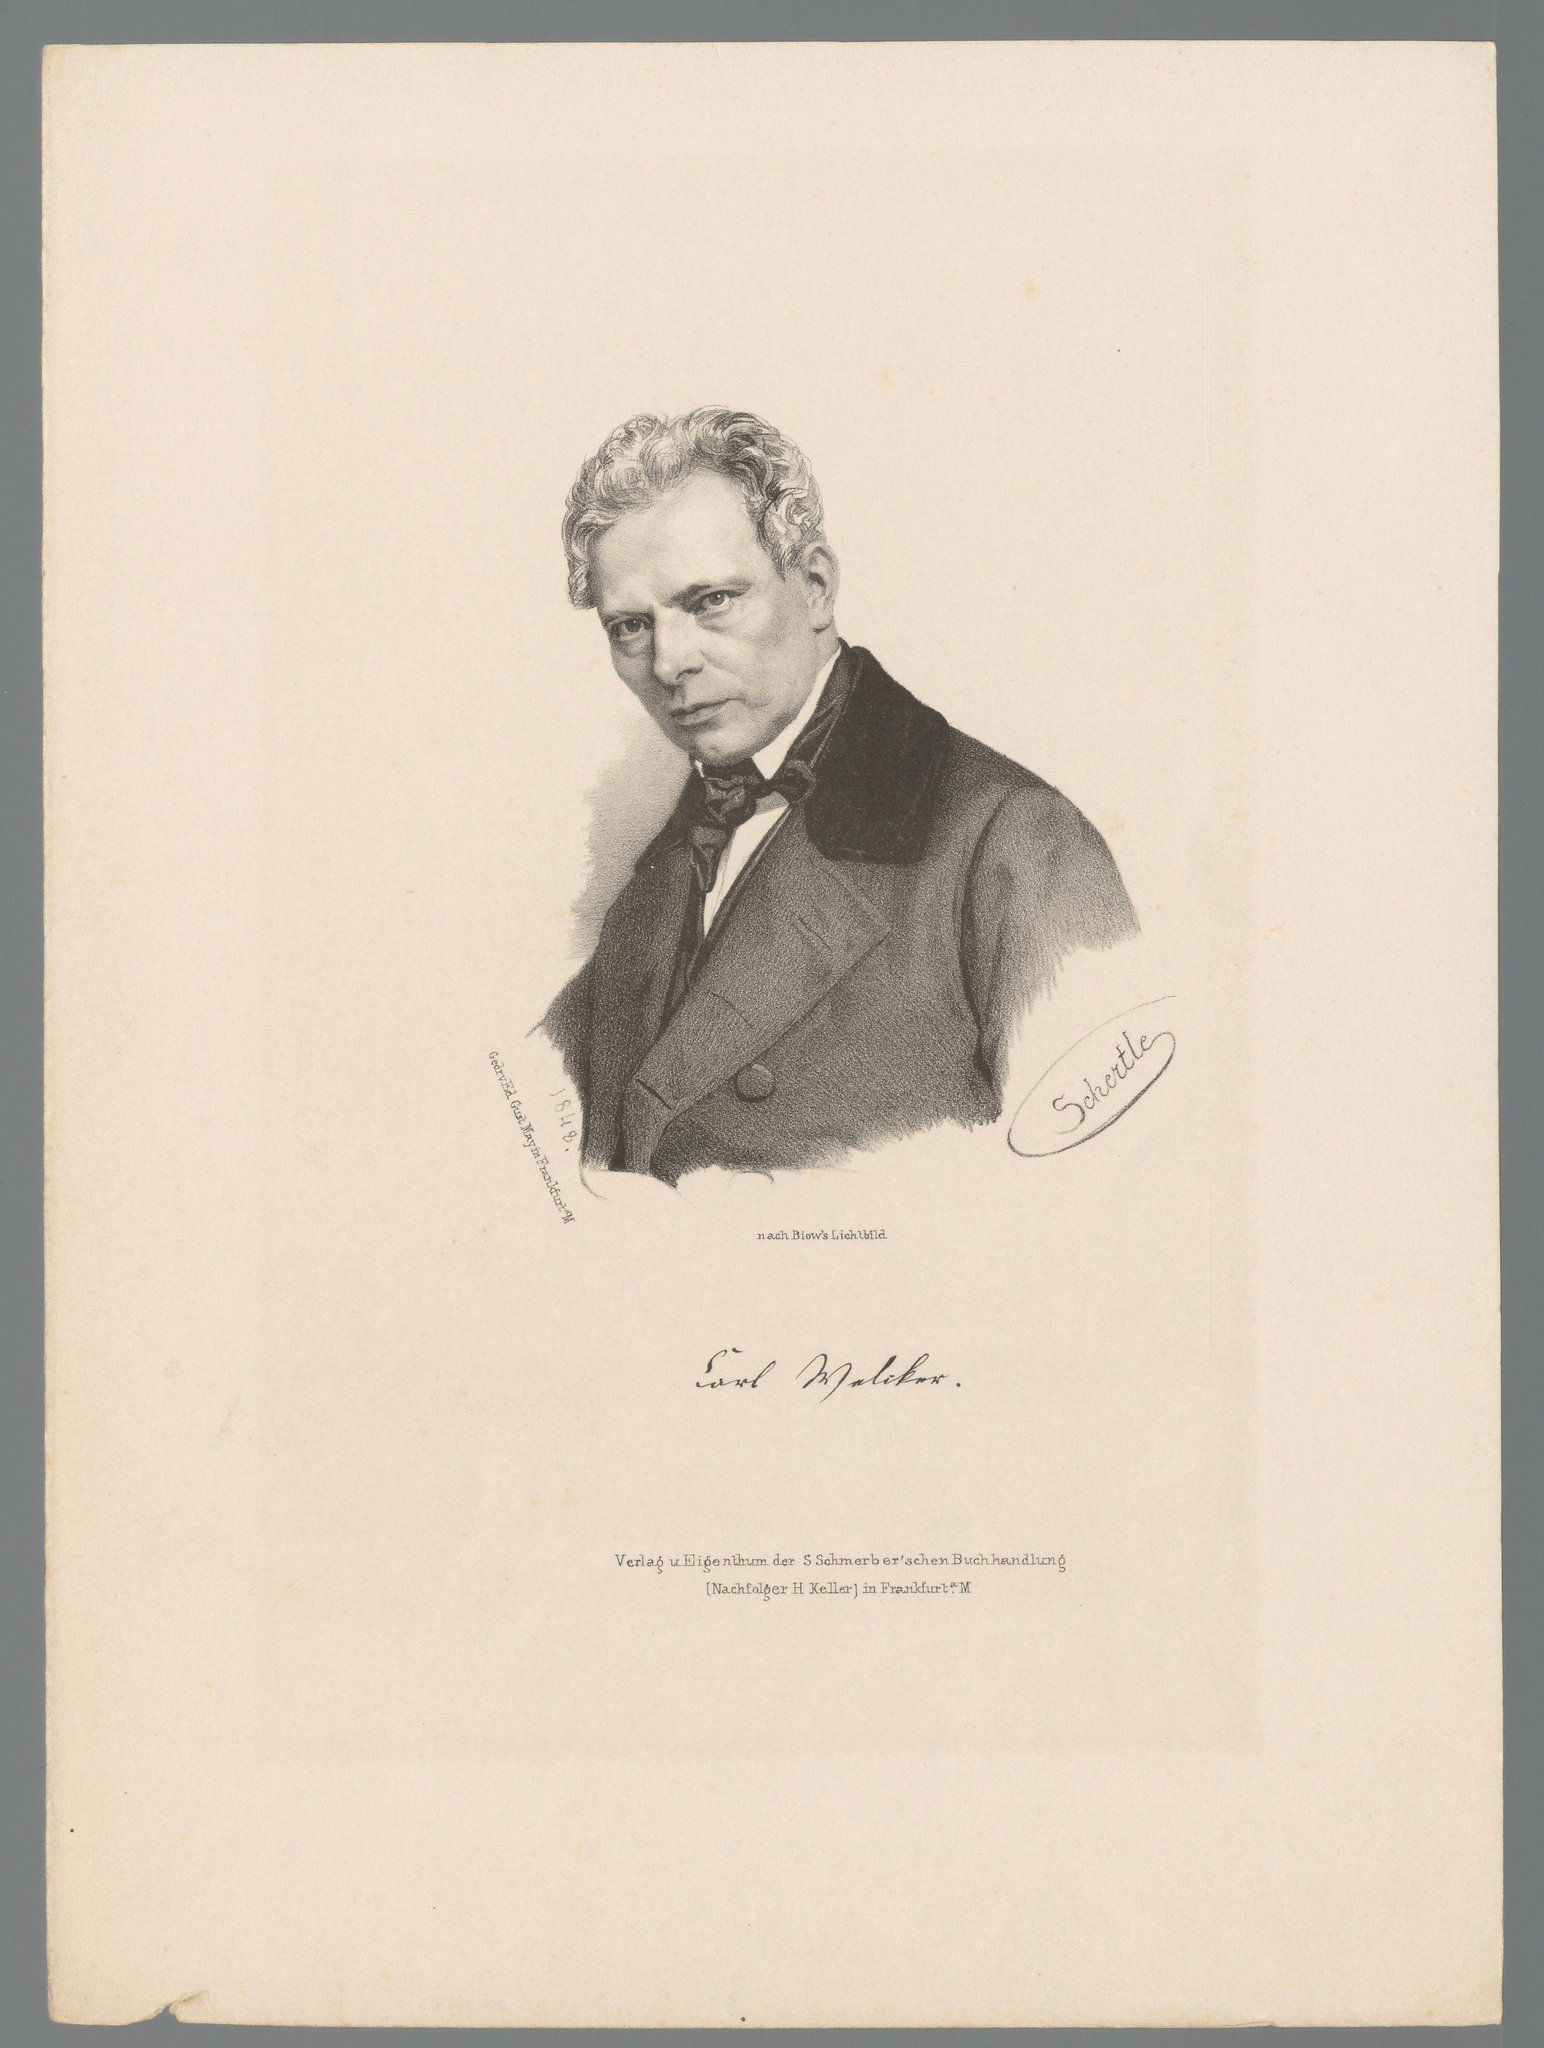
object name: print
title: Portret van een onbekende man, mogelijk Karl Welcher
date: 1848-1849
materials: paper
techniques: lithograph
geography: frankfurt am main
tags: adult man, historical persons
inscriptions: collector's mark: Lugt 2228